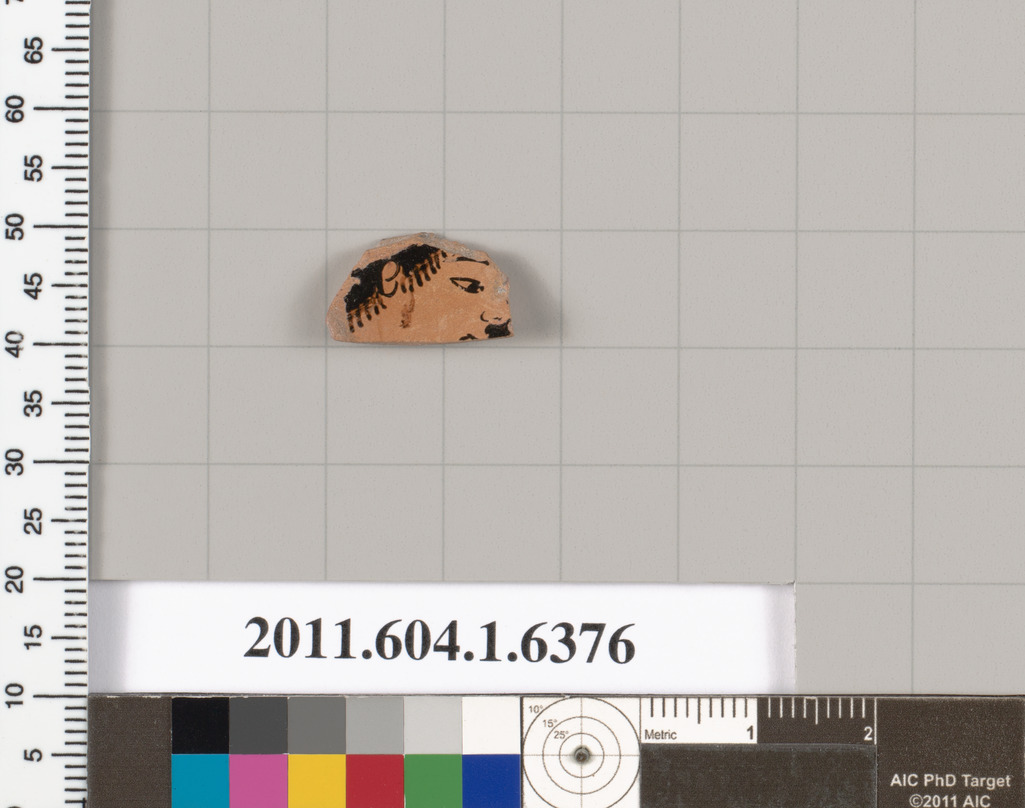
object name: kylix fragment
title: Terracotta fragment of a kylix (drinking cup)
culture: greek, attic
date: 490-480 BCE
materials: terracotta